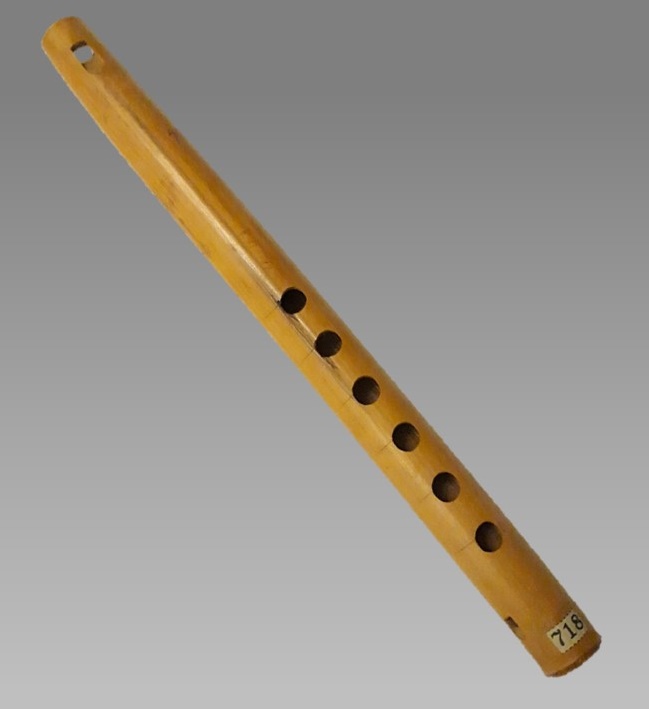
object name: whistle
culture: native american or brazilian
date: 1801-1900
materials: bamboo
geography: brazil